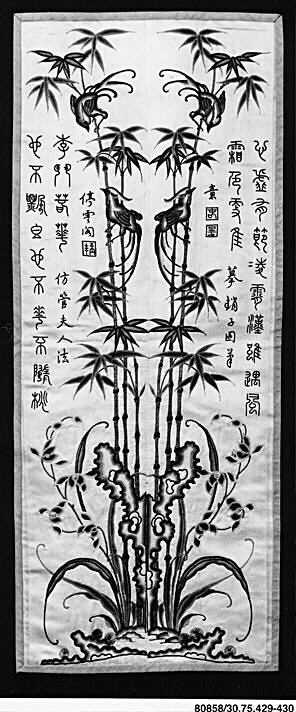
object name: sleeve band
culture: chinese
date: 1801-1900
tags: bamboo